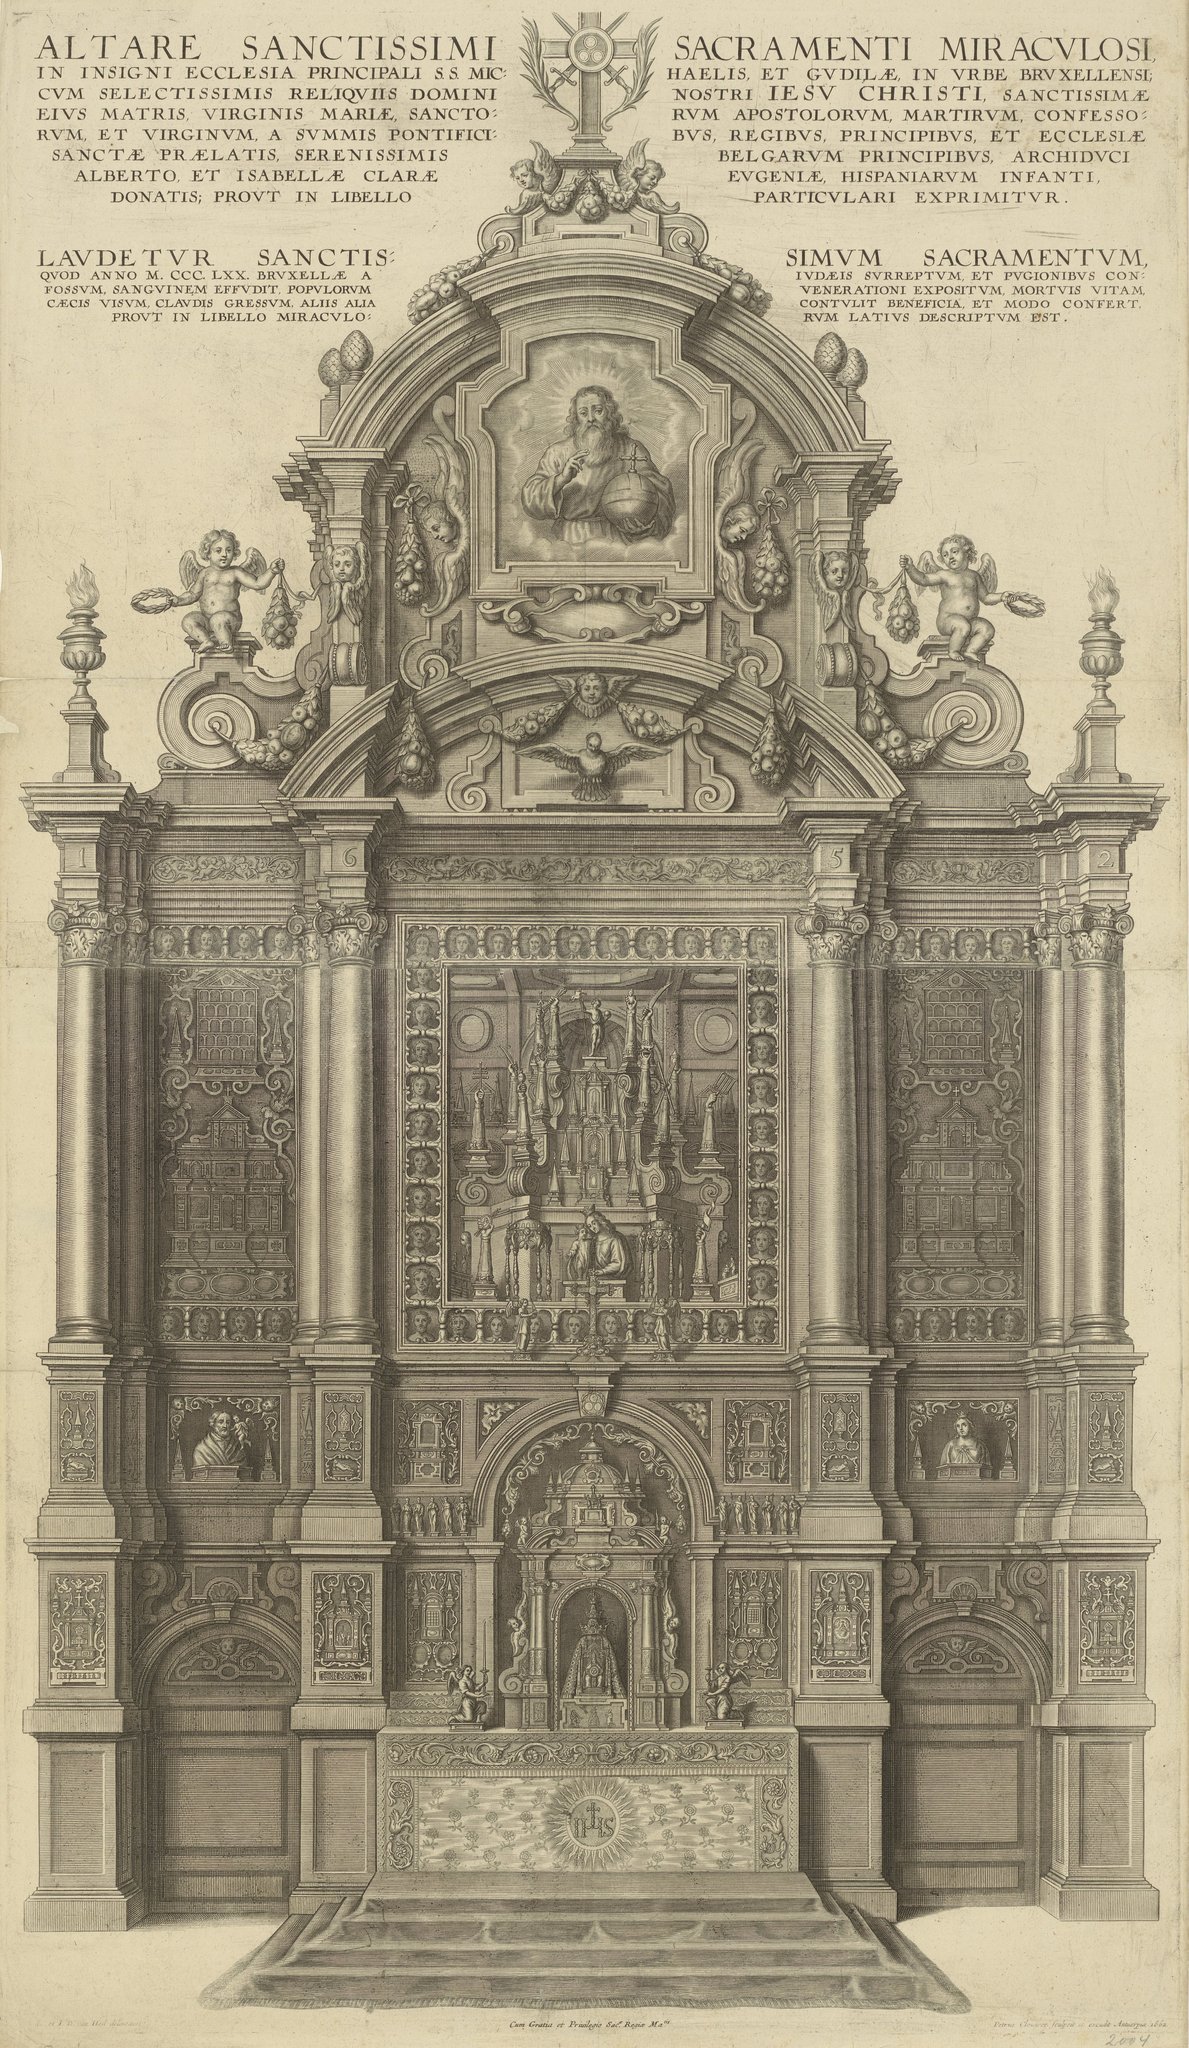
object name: print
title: Sacramentsaltaar in de Sint Michaelkerk te Brussel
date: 1662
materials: paper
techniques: engraving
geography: antwerp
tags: the seven sacraments symbolized, fixed altar, brussels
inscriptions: collector's mark: Lugt 2228